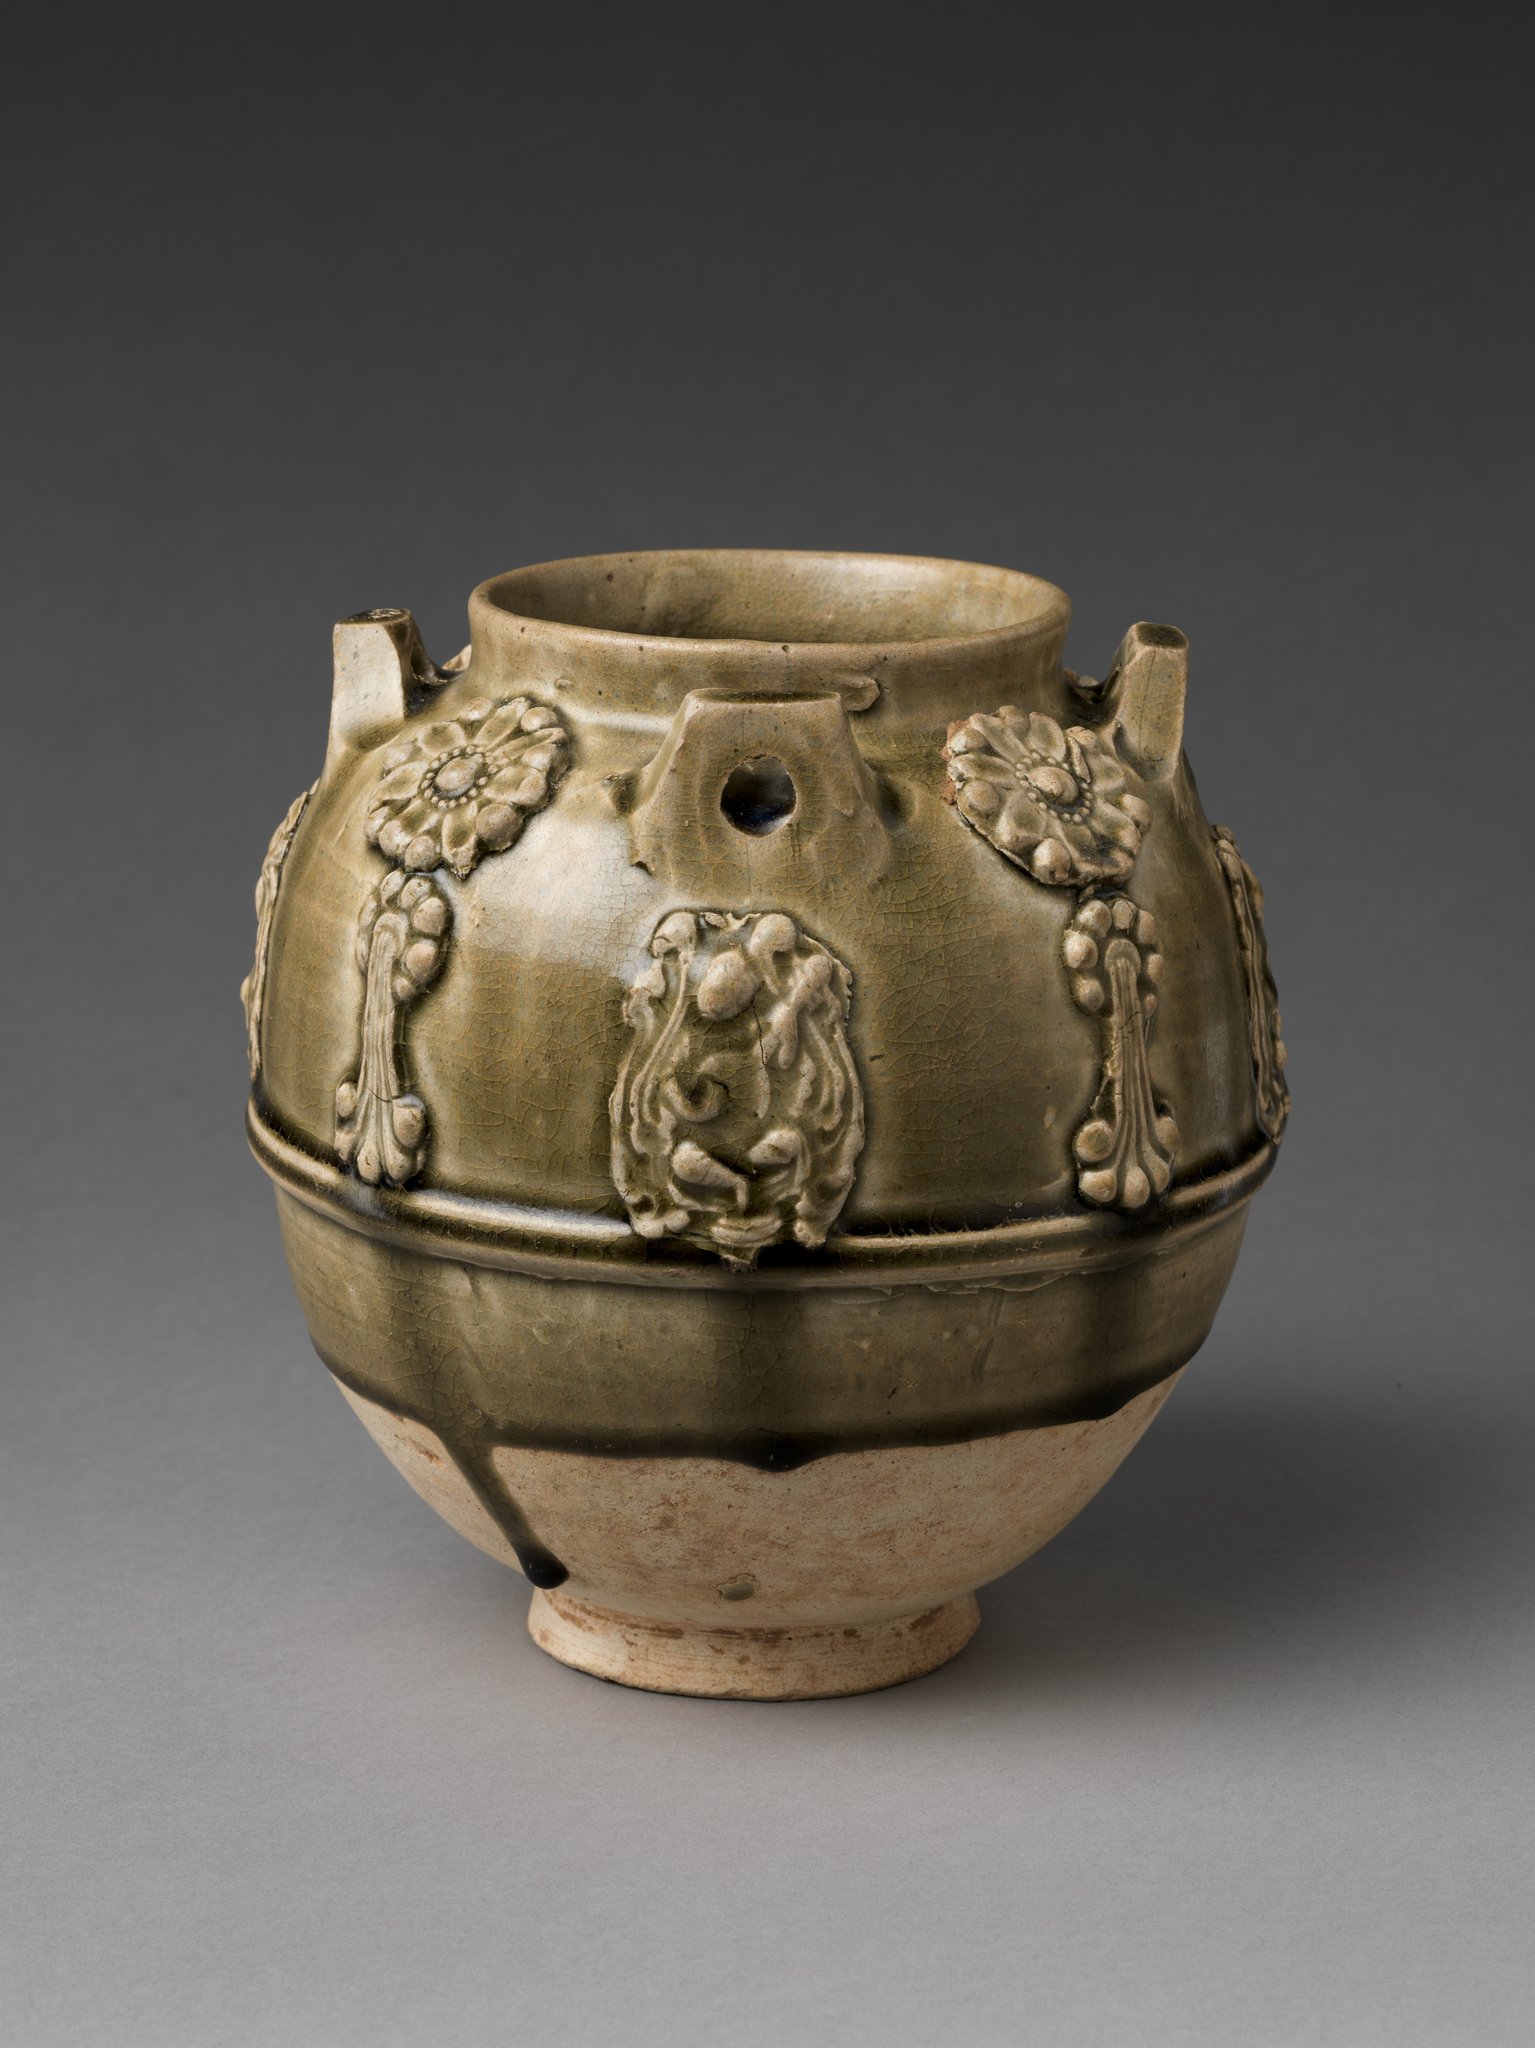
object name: jar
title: Jar with floral decorations and musicians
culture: chinese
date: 567-600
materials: ceramic glaze, glaze, stoneware